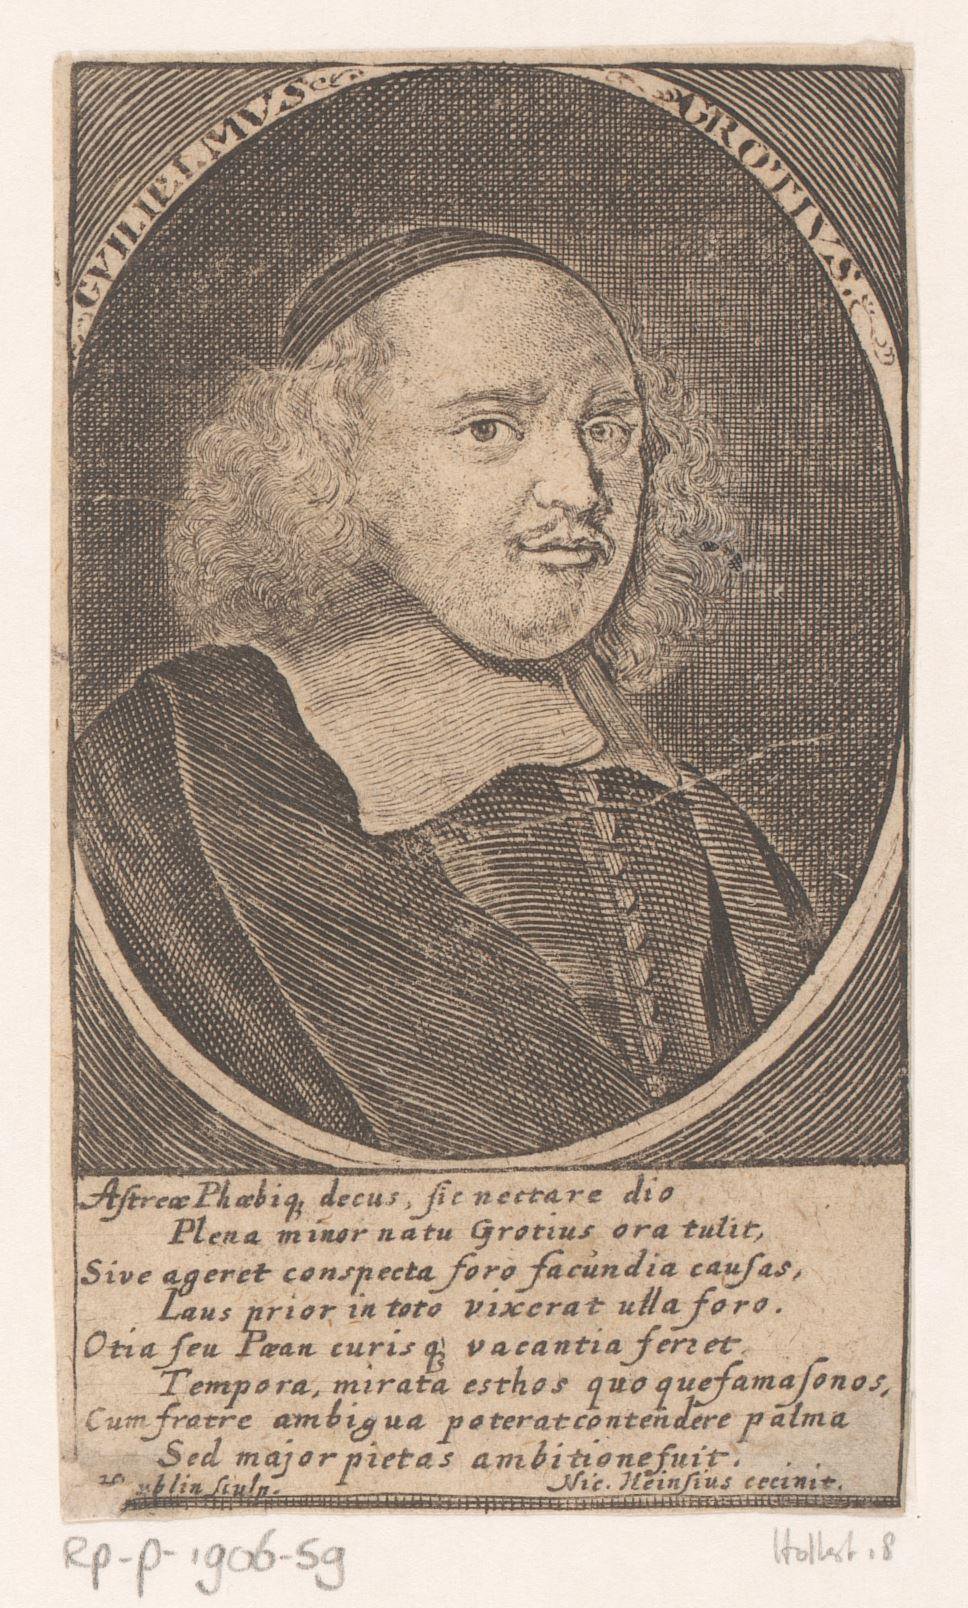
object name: print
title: Portret van Willem de Groot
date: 1681-1685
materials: paper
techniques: engraving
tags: willem de groot (1597-1662), historical persons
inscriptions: collector's mark: Lugt 2228